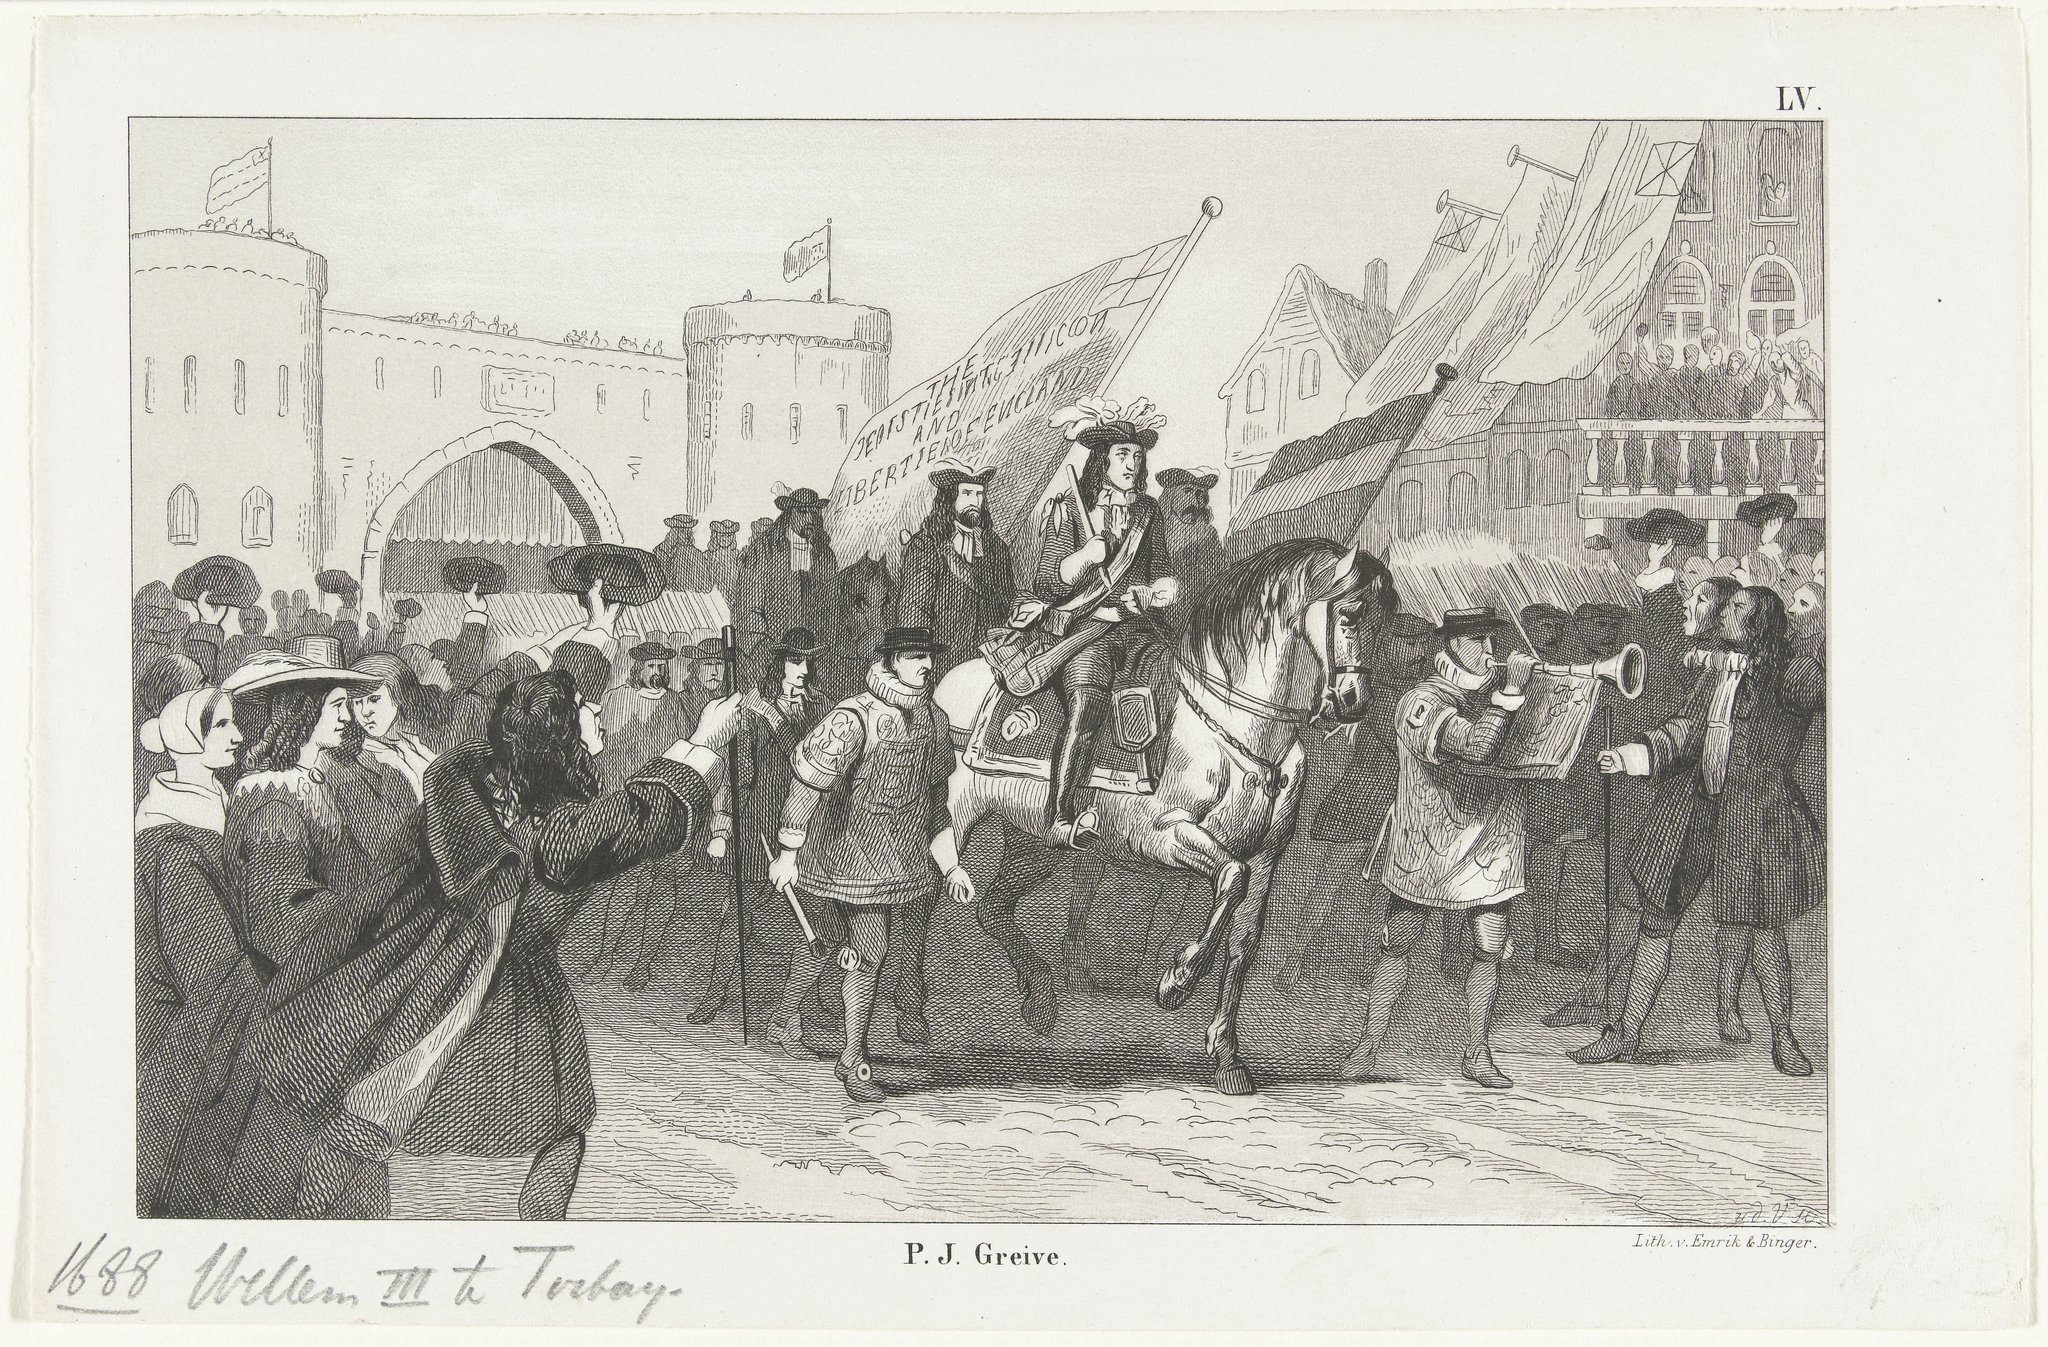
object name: print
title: Intocht van Willem III in Torbay, 1688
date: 1853-1861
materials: paper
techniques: tone lithography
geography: netherlands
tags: william iii (prince of orange and king of england, scotland, and ireland), triumphal entry and public reception, pageant, 'entrée solennelle', 'joyeuse entrée'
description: Gebruikt als illustratie in: Jacob van Lennep, De geschiedenis des vaderlands in schetsen en afbeeldingen, Binger, Amsterdam 1855-1861, 8 delen, pl. LV. Dit nummer is een door het RPK toegevoegd nummer en staat niet in Frederik Muller, het werk waar de prent voor is gemaakt of uit afkomstig is, staat wel vermeld in Frederik Muller.